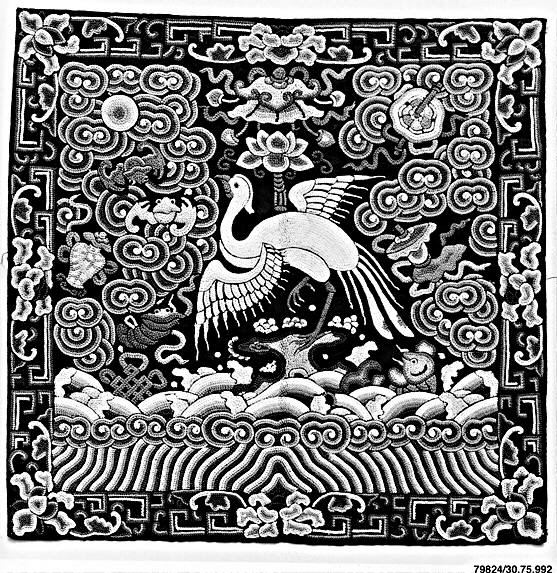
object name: rank badge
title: Rank Badge with Paradise Fly-Catcher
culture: chinese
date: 1767-1833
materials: silk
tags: bats,birds